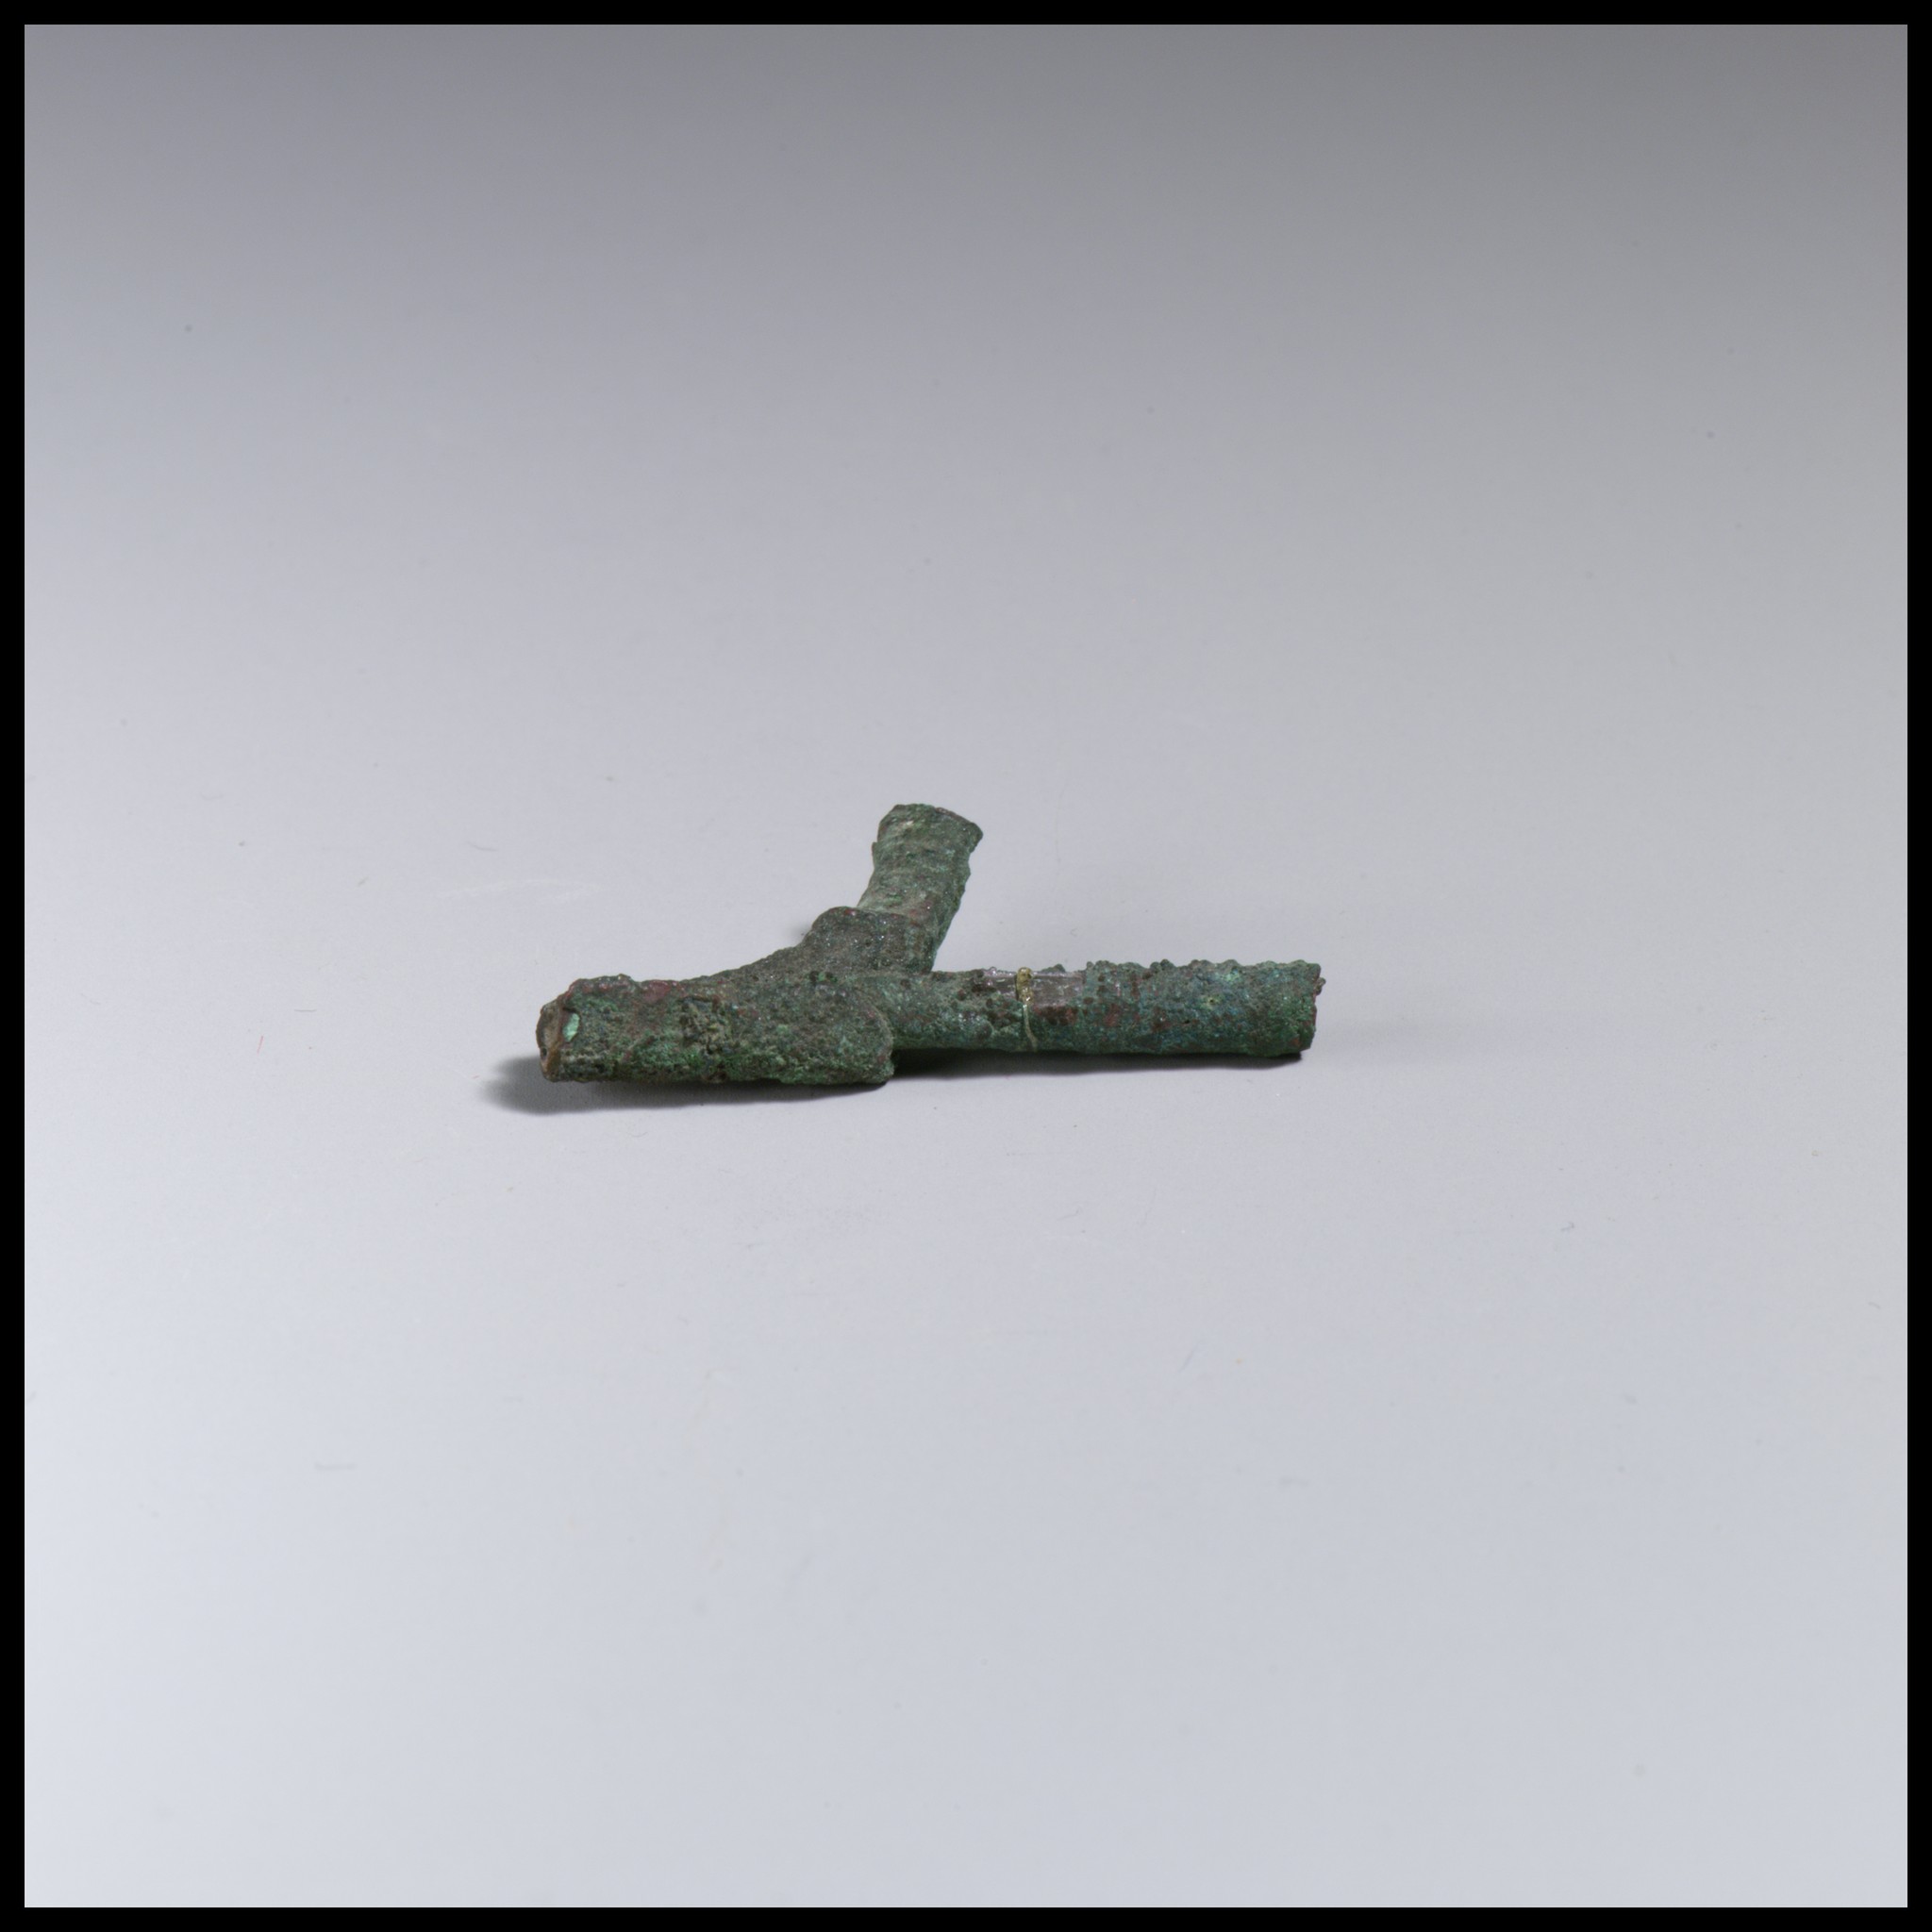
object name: fibula, fragment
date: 7000 BCE-330 CE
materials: bronze